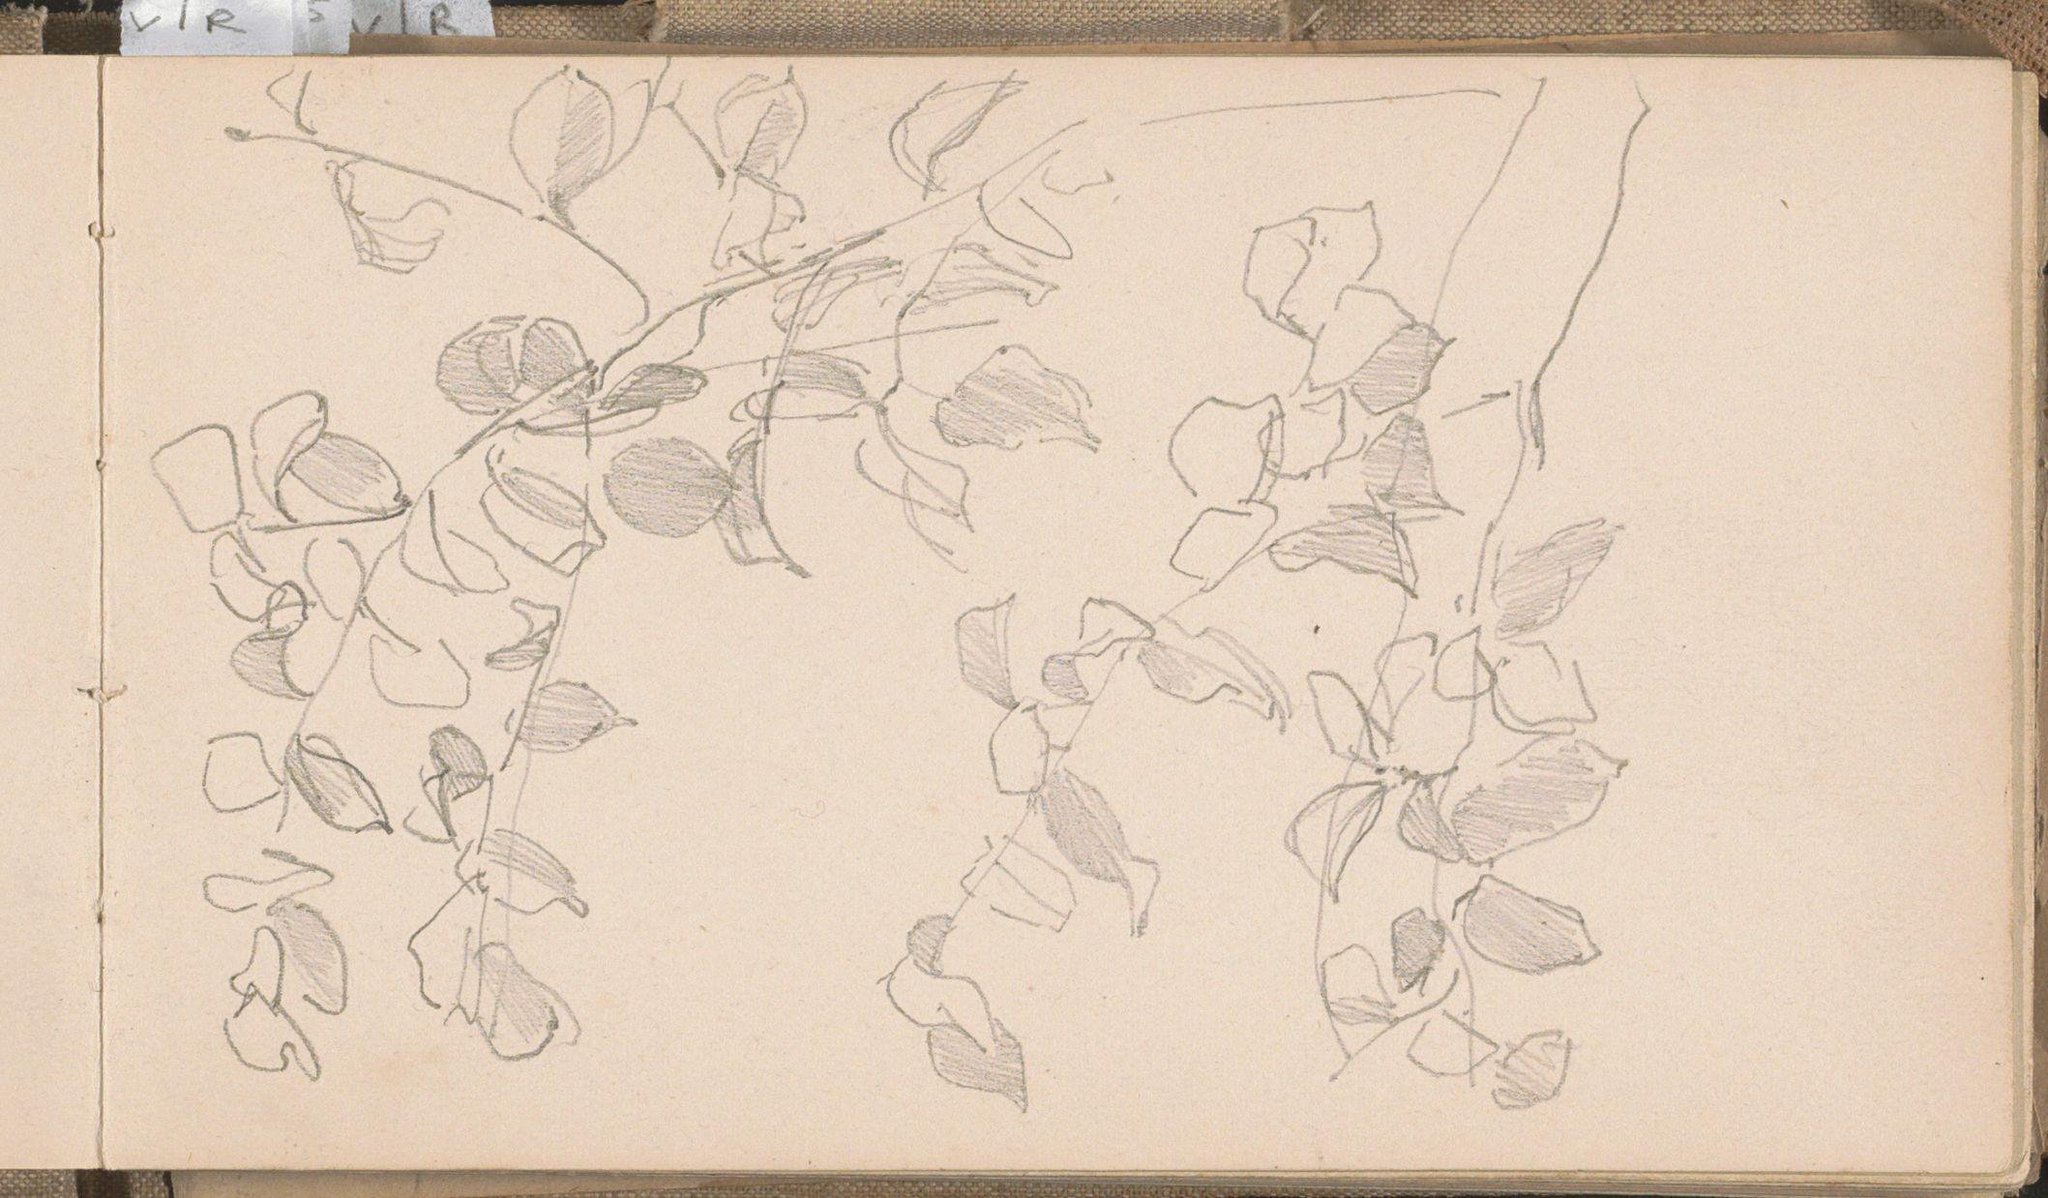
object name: sketchbook leaf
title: Takken met bladeren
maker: antoon derkinderen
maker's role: draughtsman, painter, print maker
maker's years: 1859-1925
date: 1892-1901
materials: paper, pencil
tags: trees (+ leaf), trees (+ branch, stick)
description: Blad 4 recto uit een schetsboek met 51 bladen.